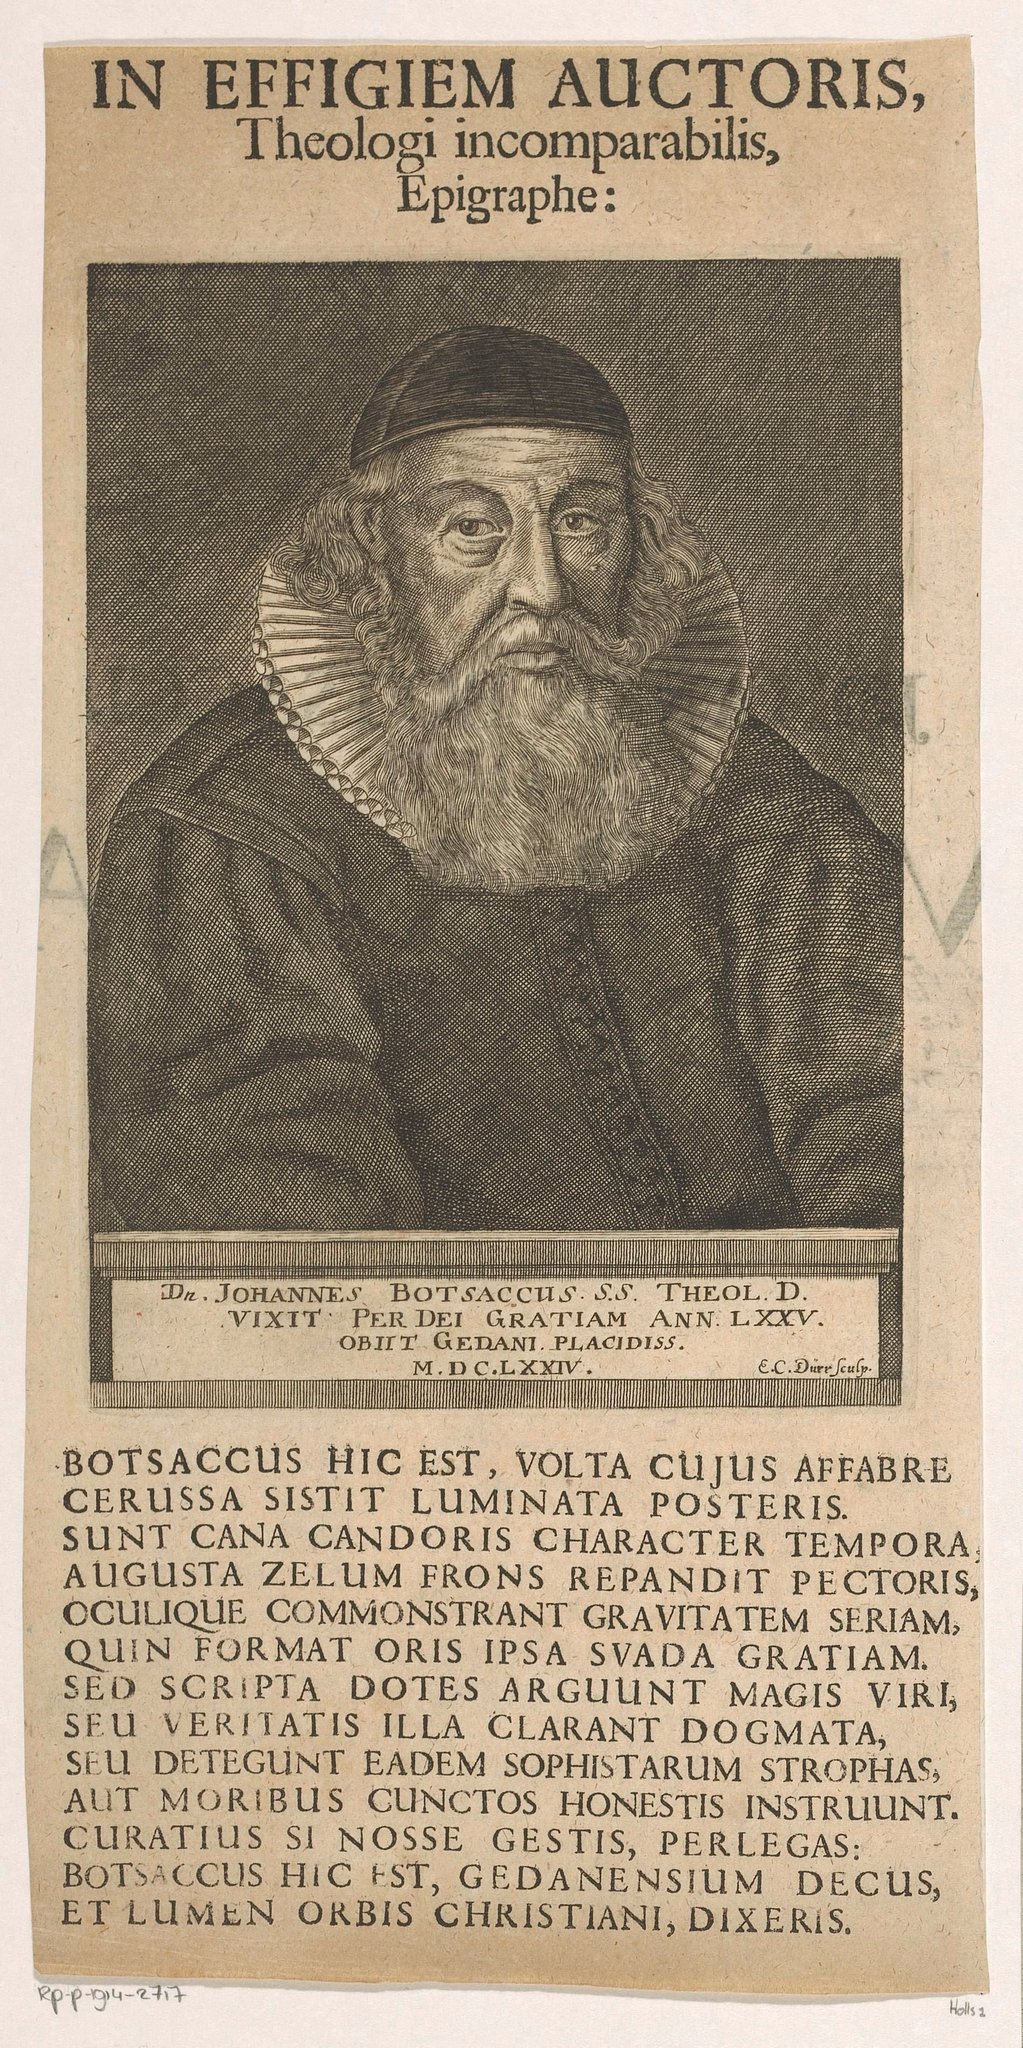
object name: print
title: Portret van Johann Botsack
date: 1712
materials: paper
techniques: engraving, letterpress printing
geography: leipzig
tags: historical persons, theology; 'theologia' (ripa)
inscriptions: collector's mark: Lugt 2228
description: Prent gebruikt voor: Botsack, Johann. Moralia Gedanensia (...) Editio novissima. Leipzig: Thomas Fritsch, 1712.